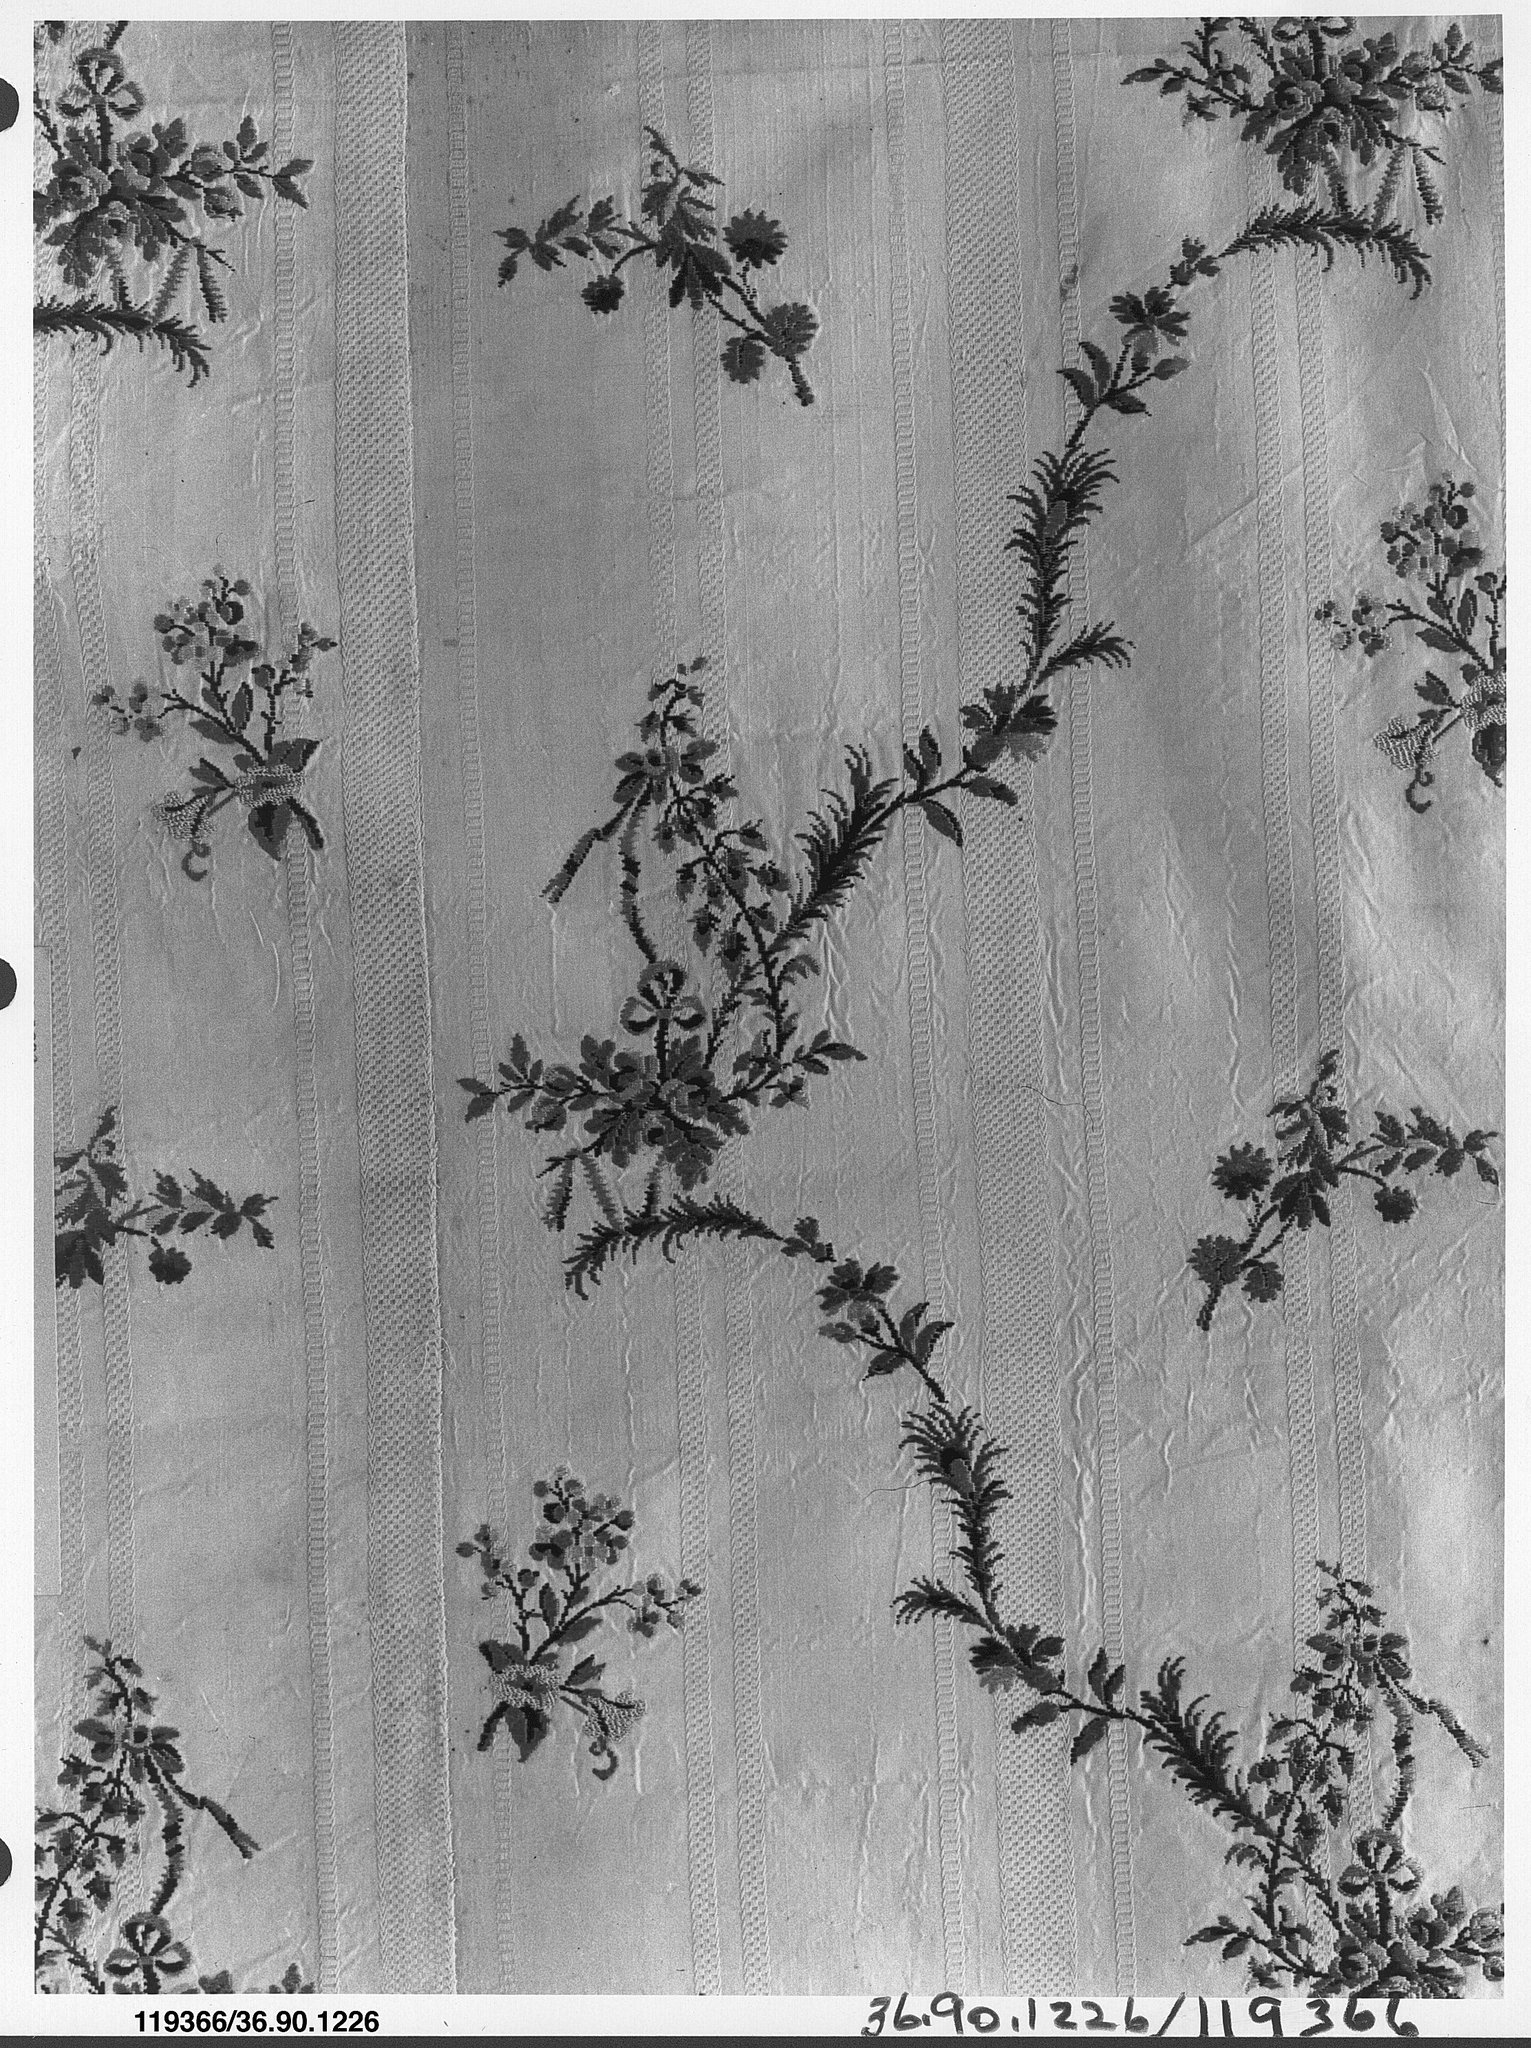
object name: piece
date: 1701-1800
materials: silk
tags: flowers,leaves